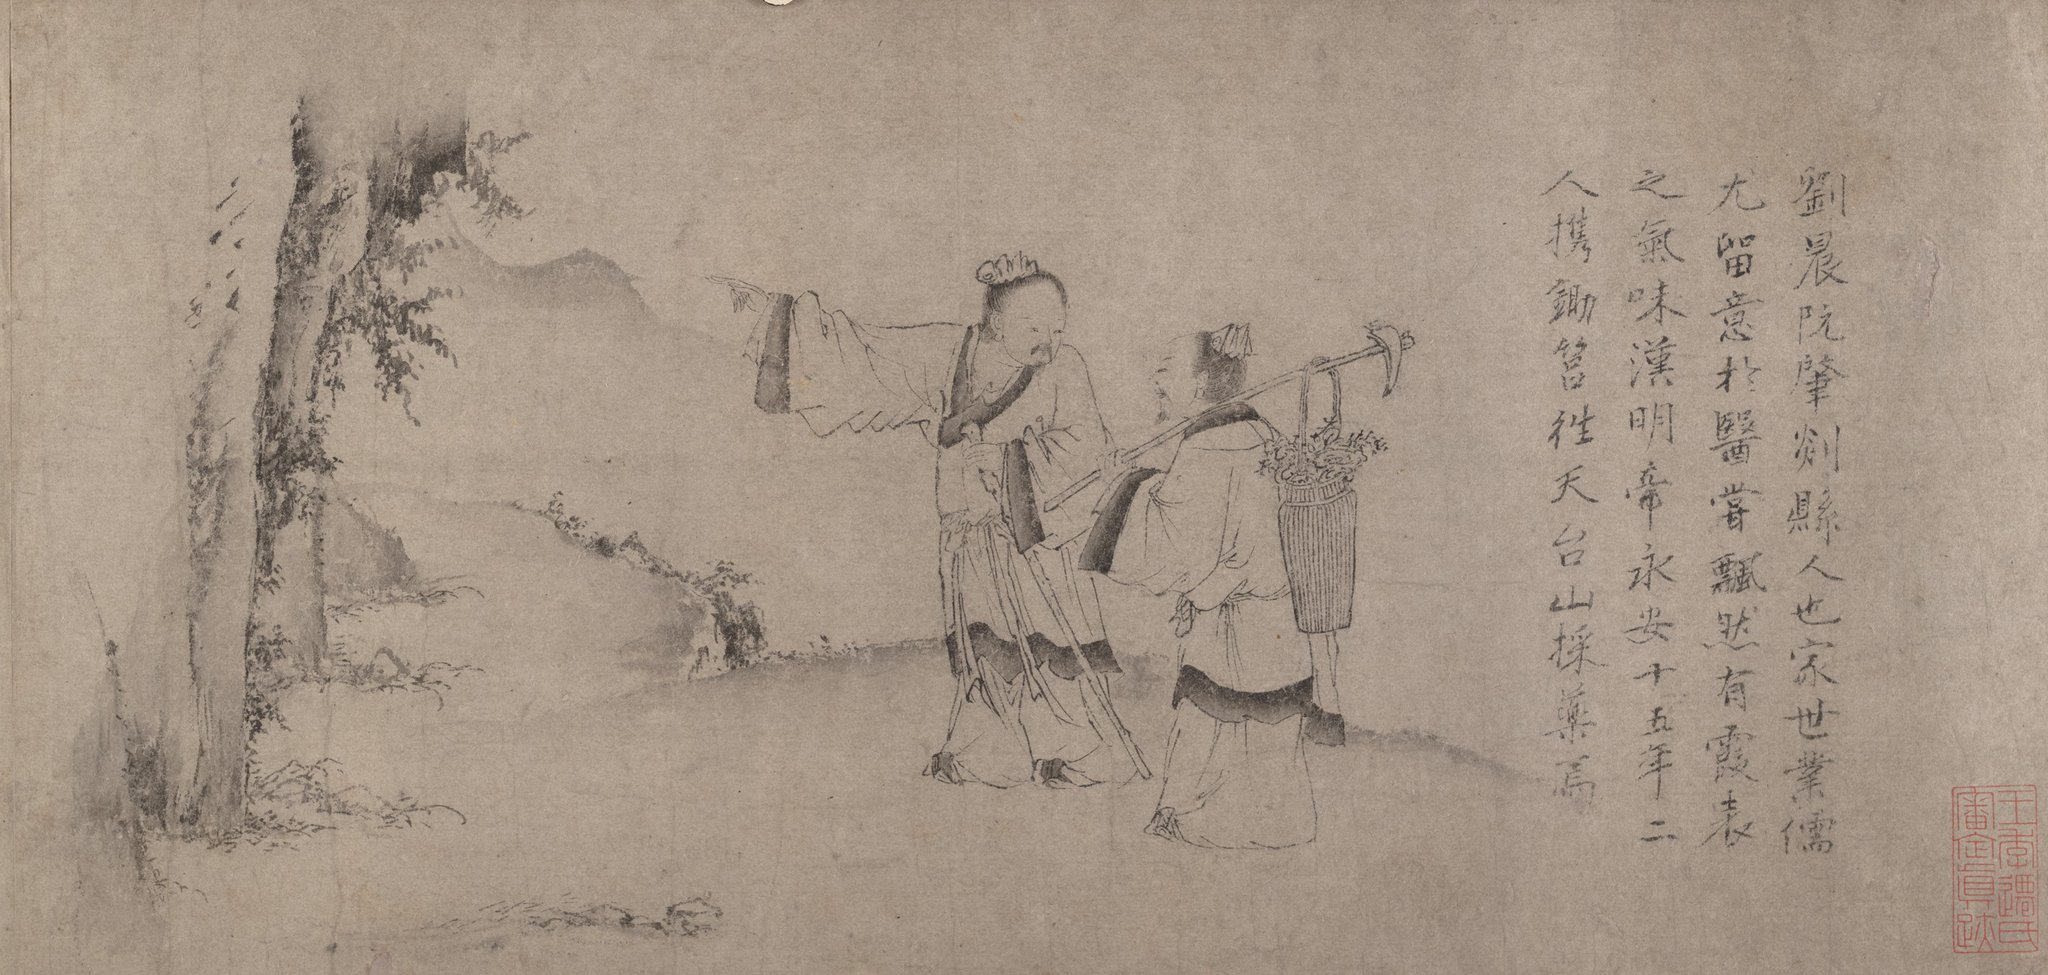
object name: handscroll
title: Liu Chen and Ruan Zhao Entering the Tiantai Mountains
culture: chinese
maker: zhao cangyun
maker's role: artist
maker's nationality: chinese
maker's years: 1267-1333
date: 1271-1333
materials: ink, paper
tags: men